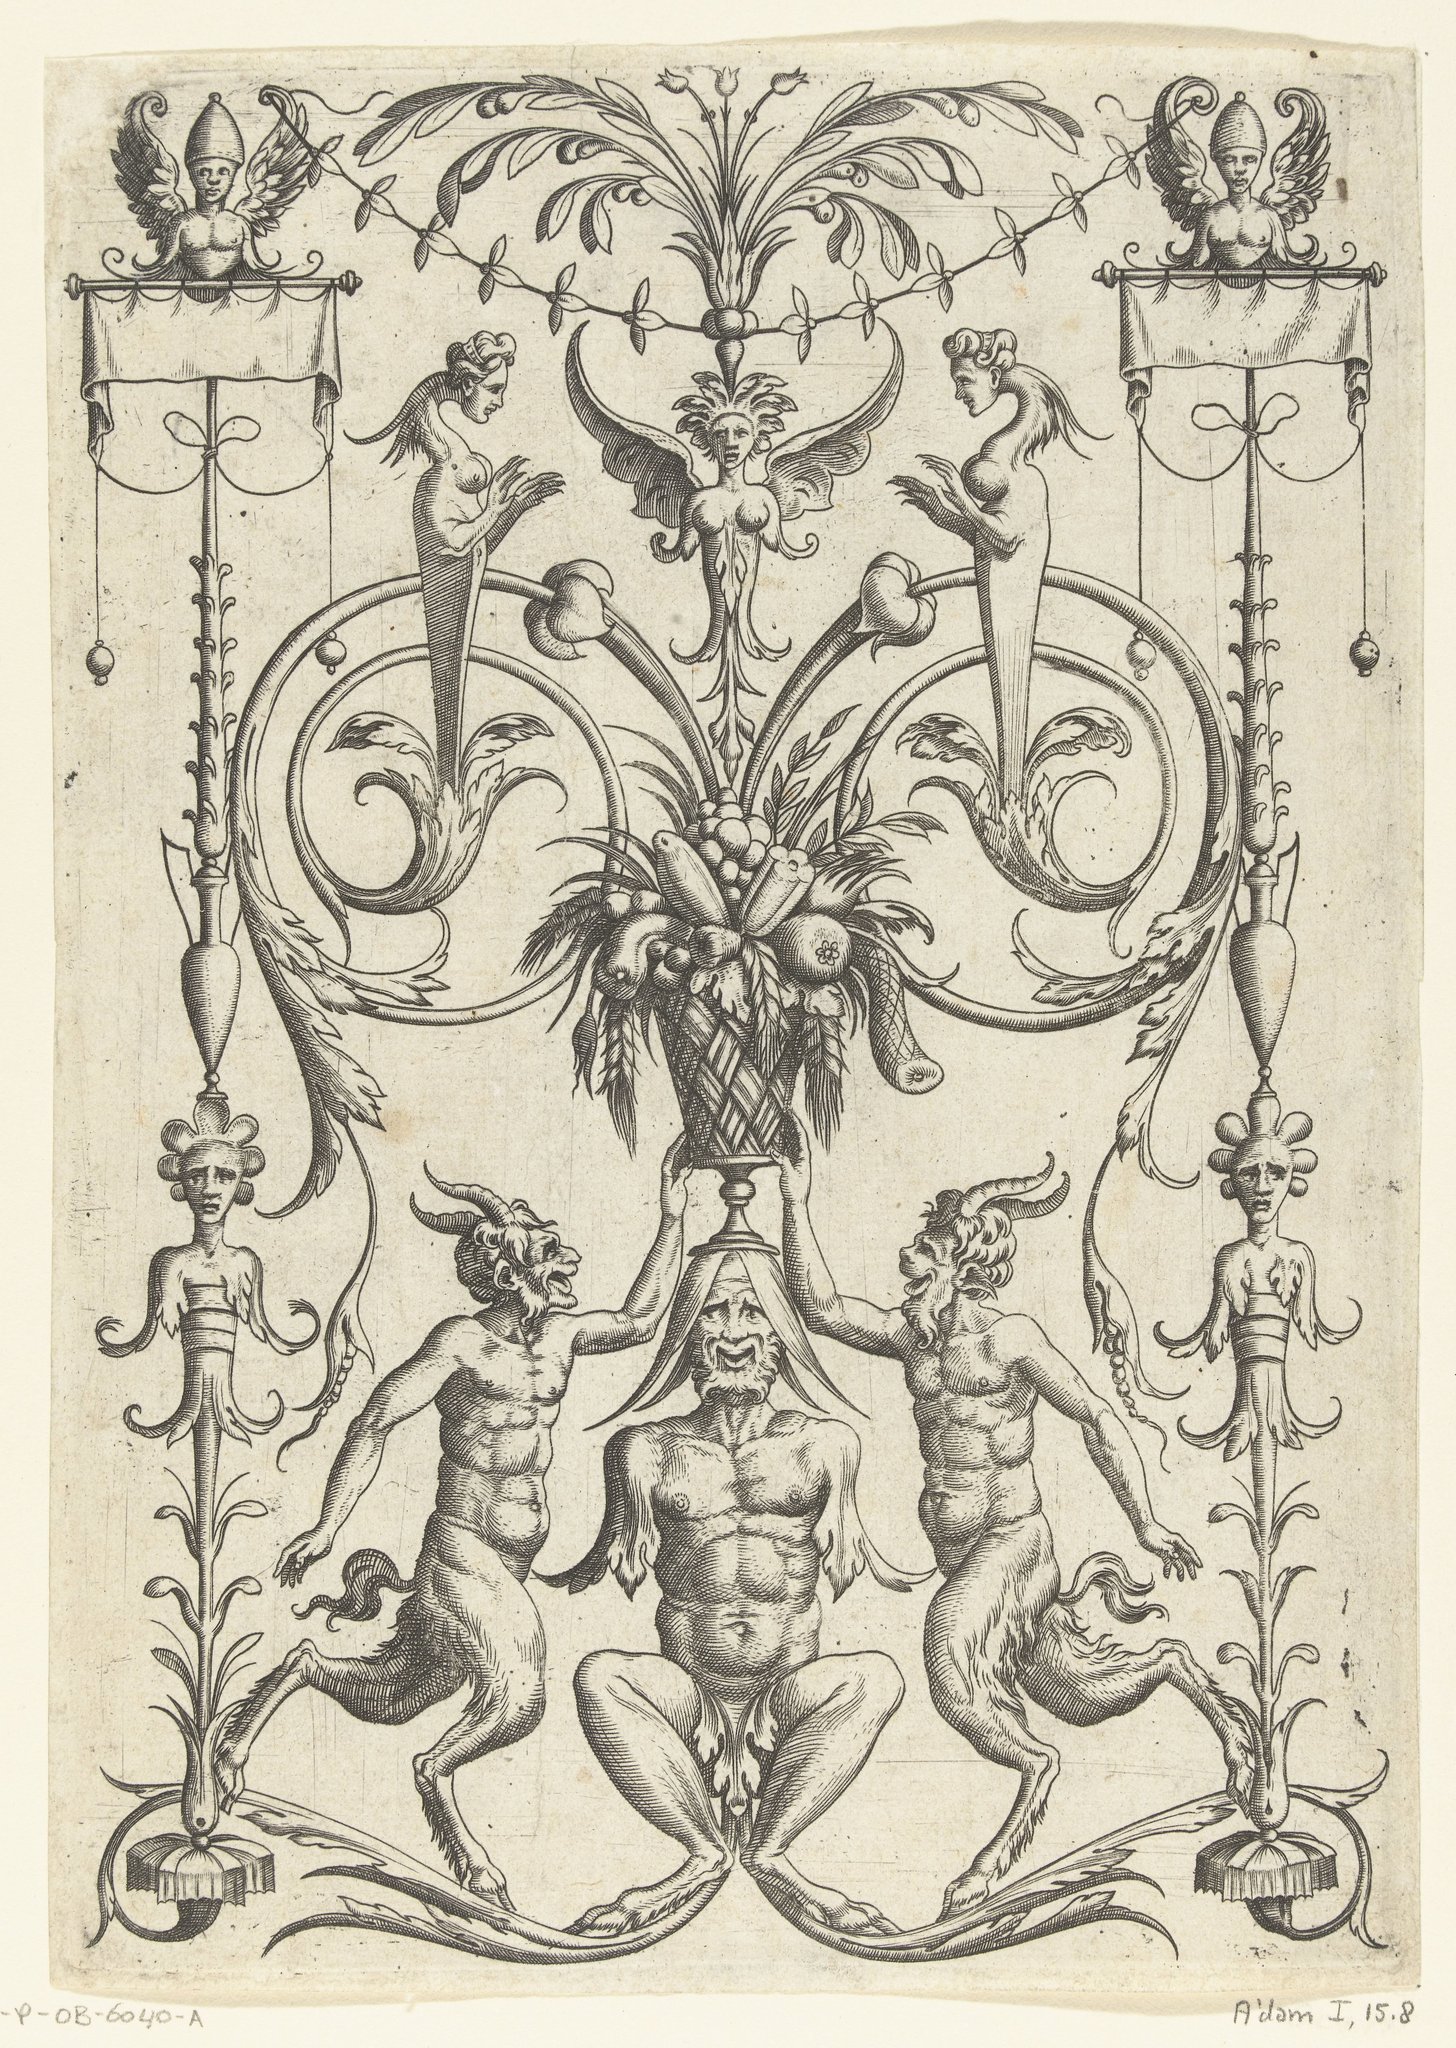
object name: print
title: Gehurkte sater zonder armen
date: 1516-1556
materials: paper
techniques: engraving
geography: netherlands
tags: ornament ~ grotesque, fruits and vegetables ~ ornament, satyr(s) (in general)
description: De sater draagt op zijn hoofd een mand met fruit, daarbij geholpen door twee saters die elk met één hand de mand ondersteunen. Blad uit serie van 9 bladen.